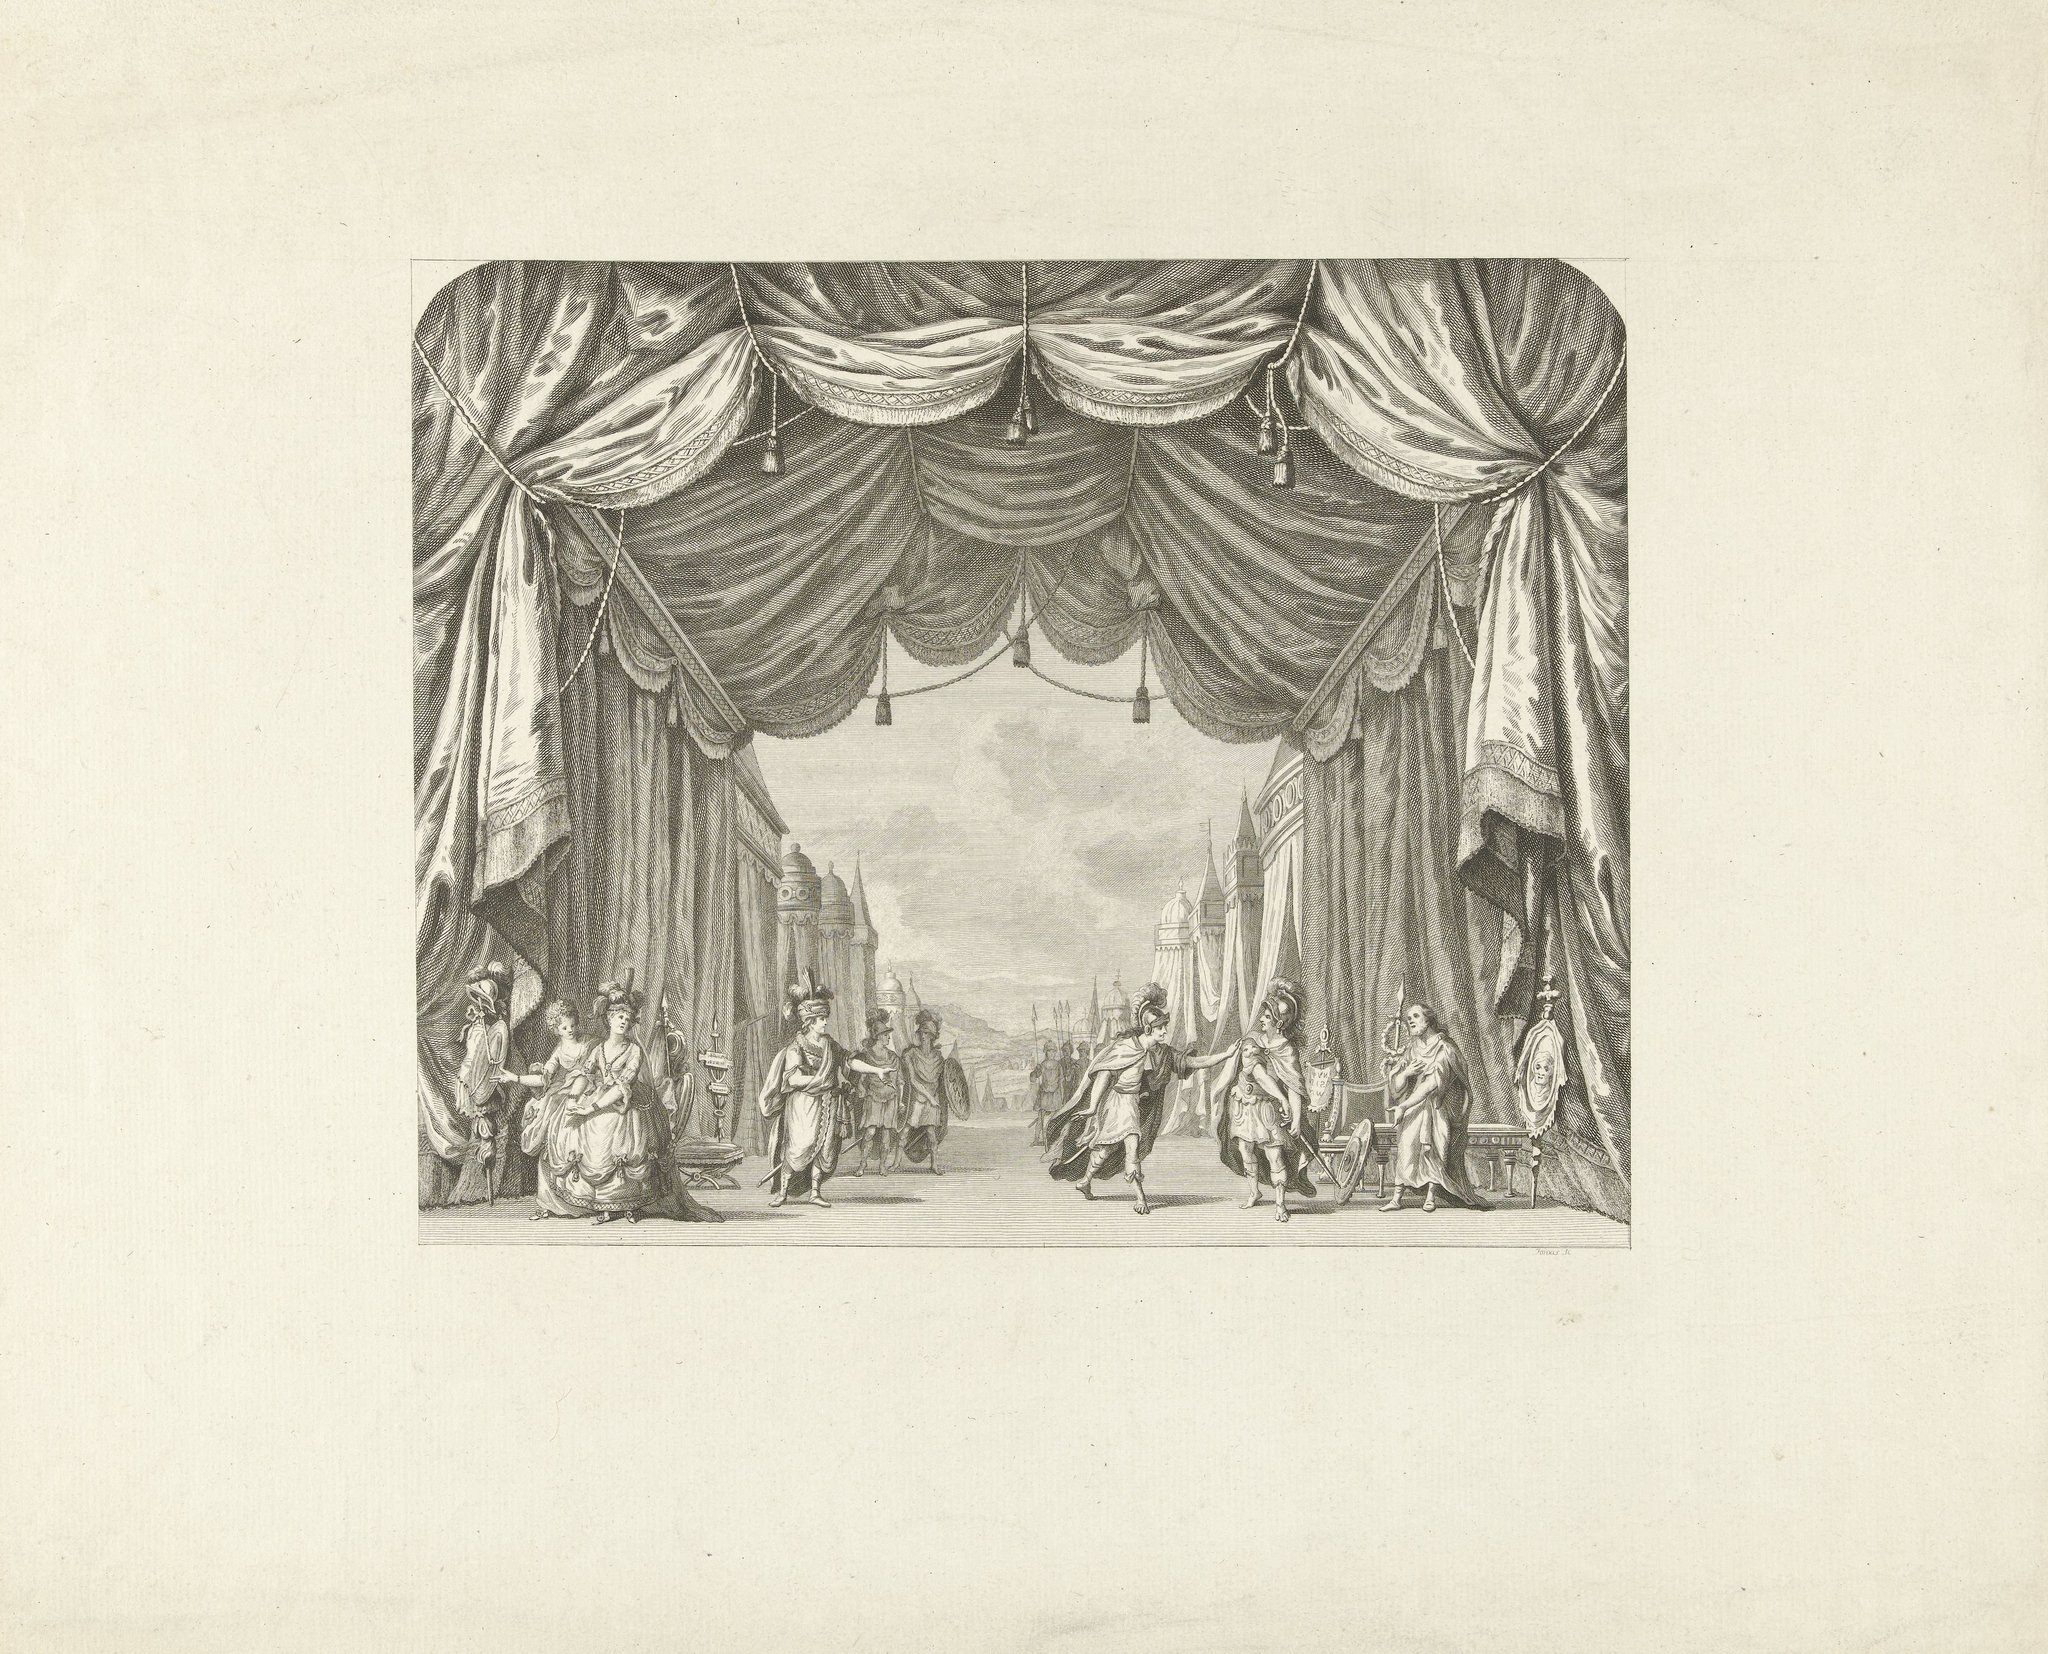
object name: print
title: Toneel met acteurs in diverse kostuums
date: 1772-1843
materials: paper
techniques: engraving, etching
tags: theatre, theatrical performance, group of actors, troupe; actors on the stage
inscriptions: collector's mark: Lugt 2228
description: Toneel met acteurs in Romeinse en Oosterse kostuums. Zij voeren een toneelstuk op. Op de voorgrond weerhoudt een Romein een ander die het zwaard wil trekken.